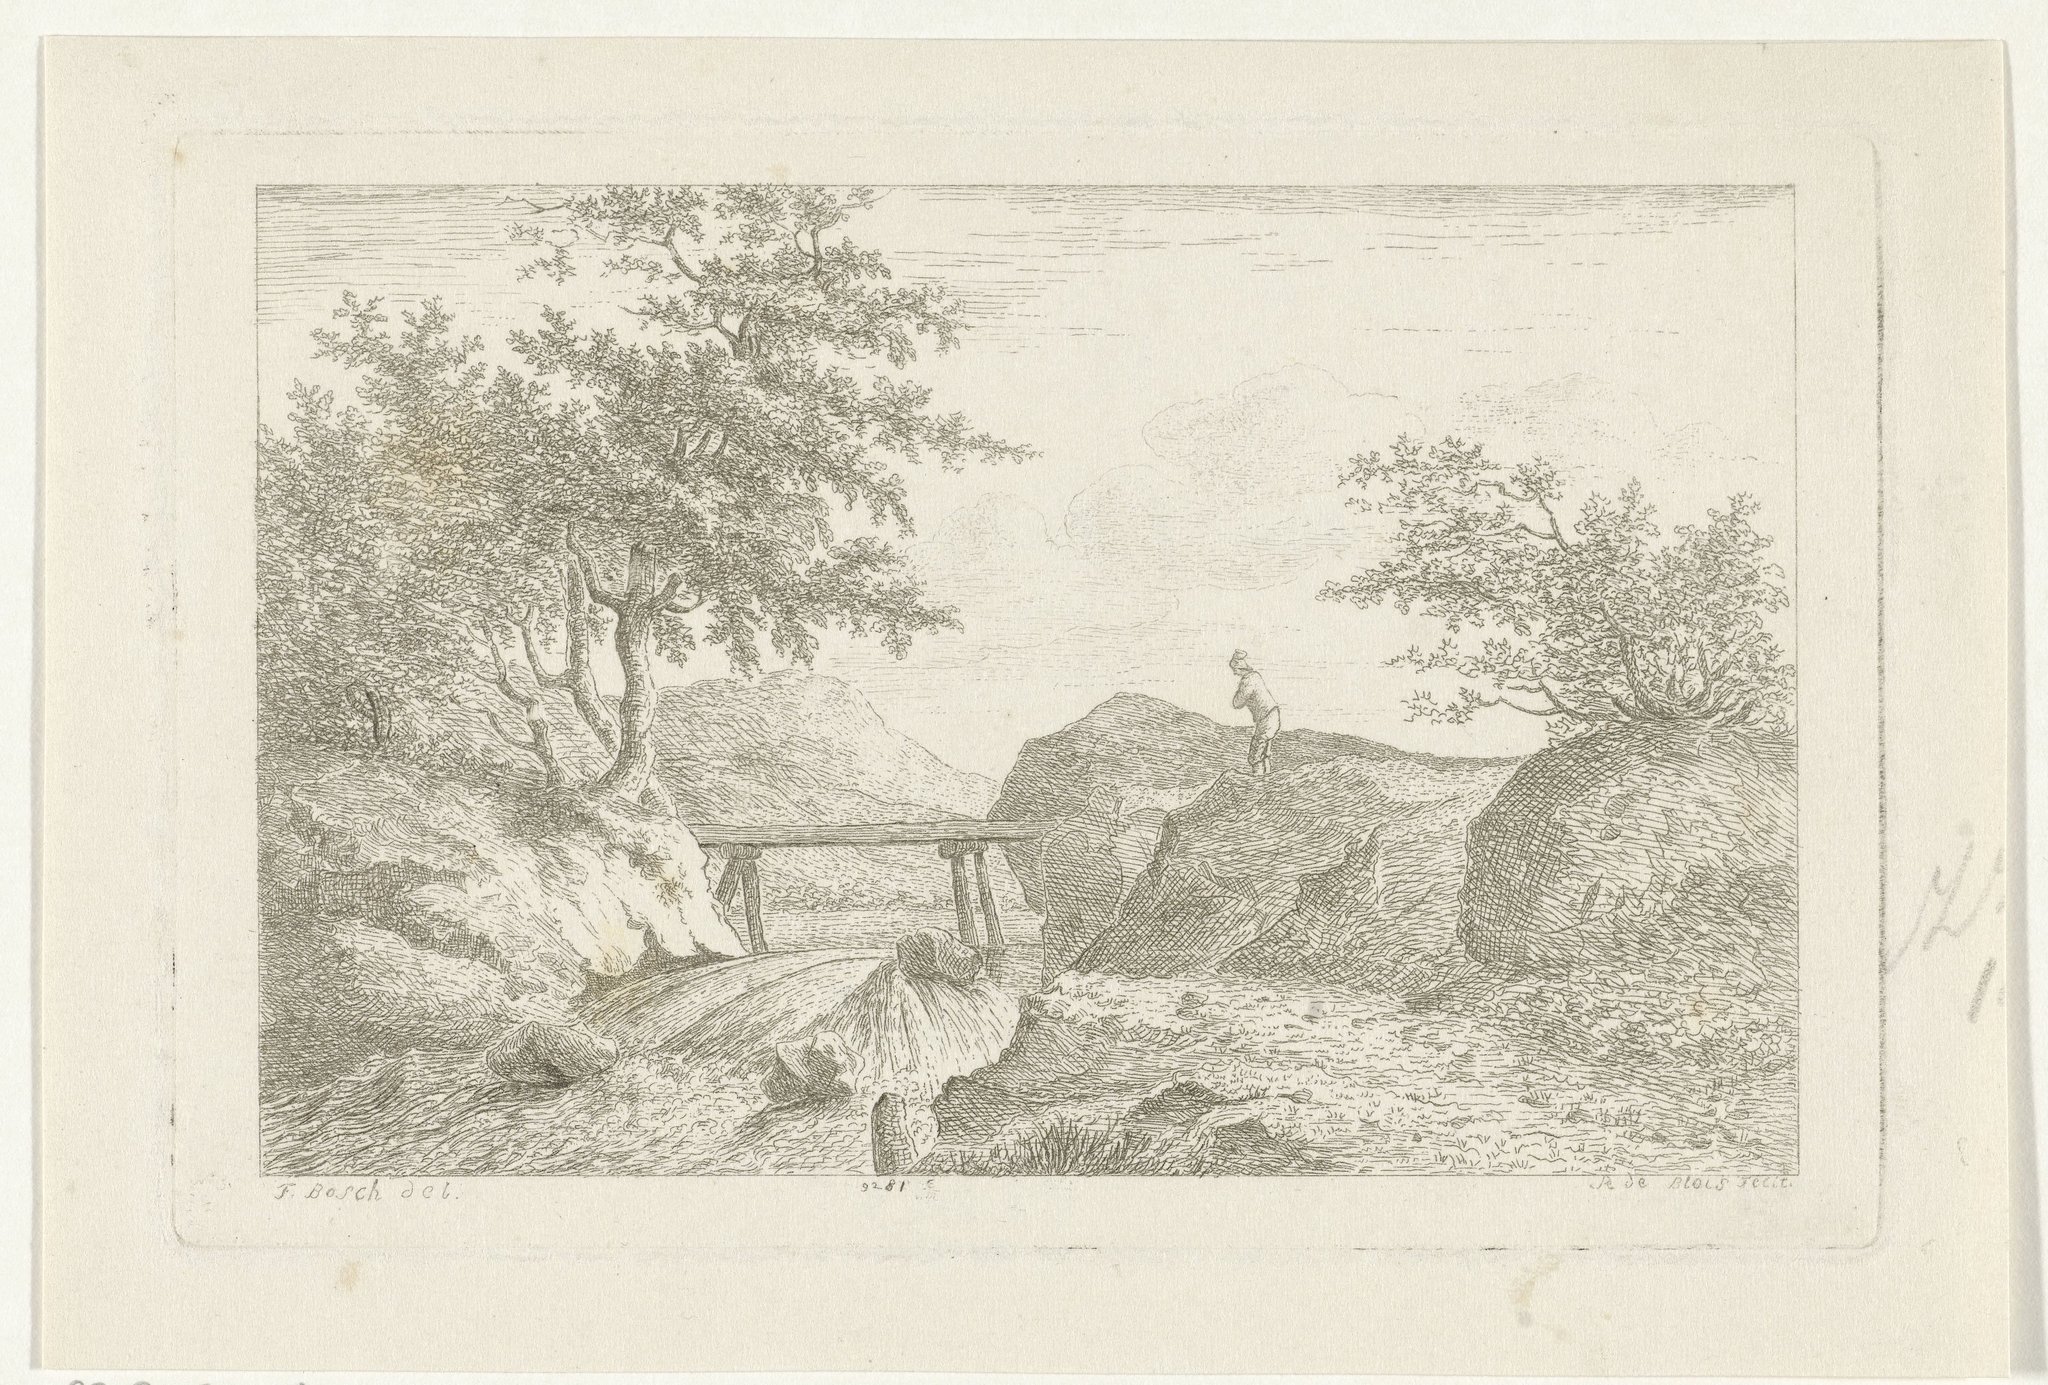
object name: print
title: Brug bij een waterval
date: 1796-1856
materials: paper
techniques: etching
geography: vaassen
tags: waterfall, bridge, landscapes (+ landscape with figures, staffage)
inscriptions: collector's mark: Lugt 2228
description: Een brug over een waterval. Rechts staat een man op een rots. Midden onder in de marge: 9281.